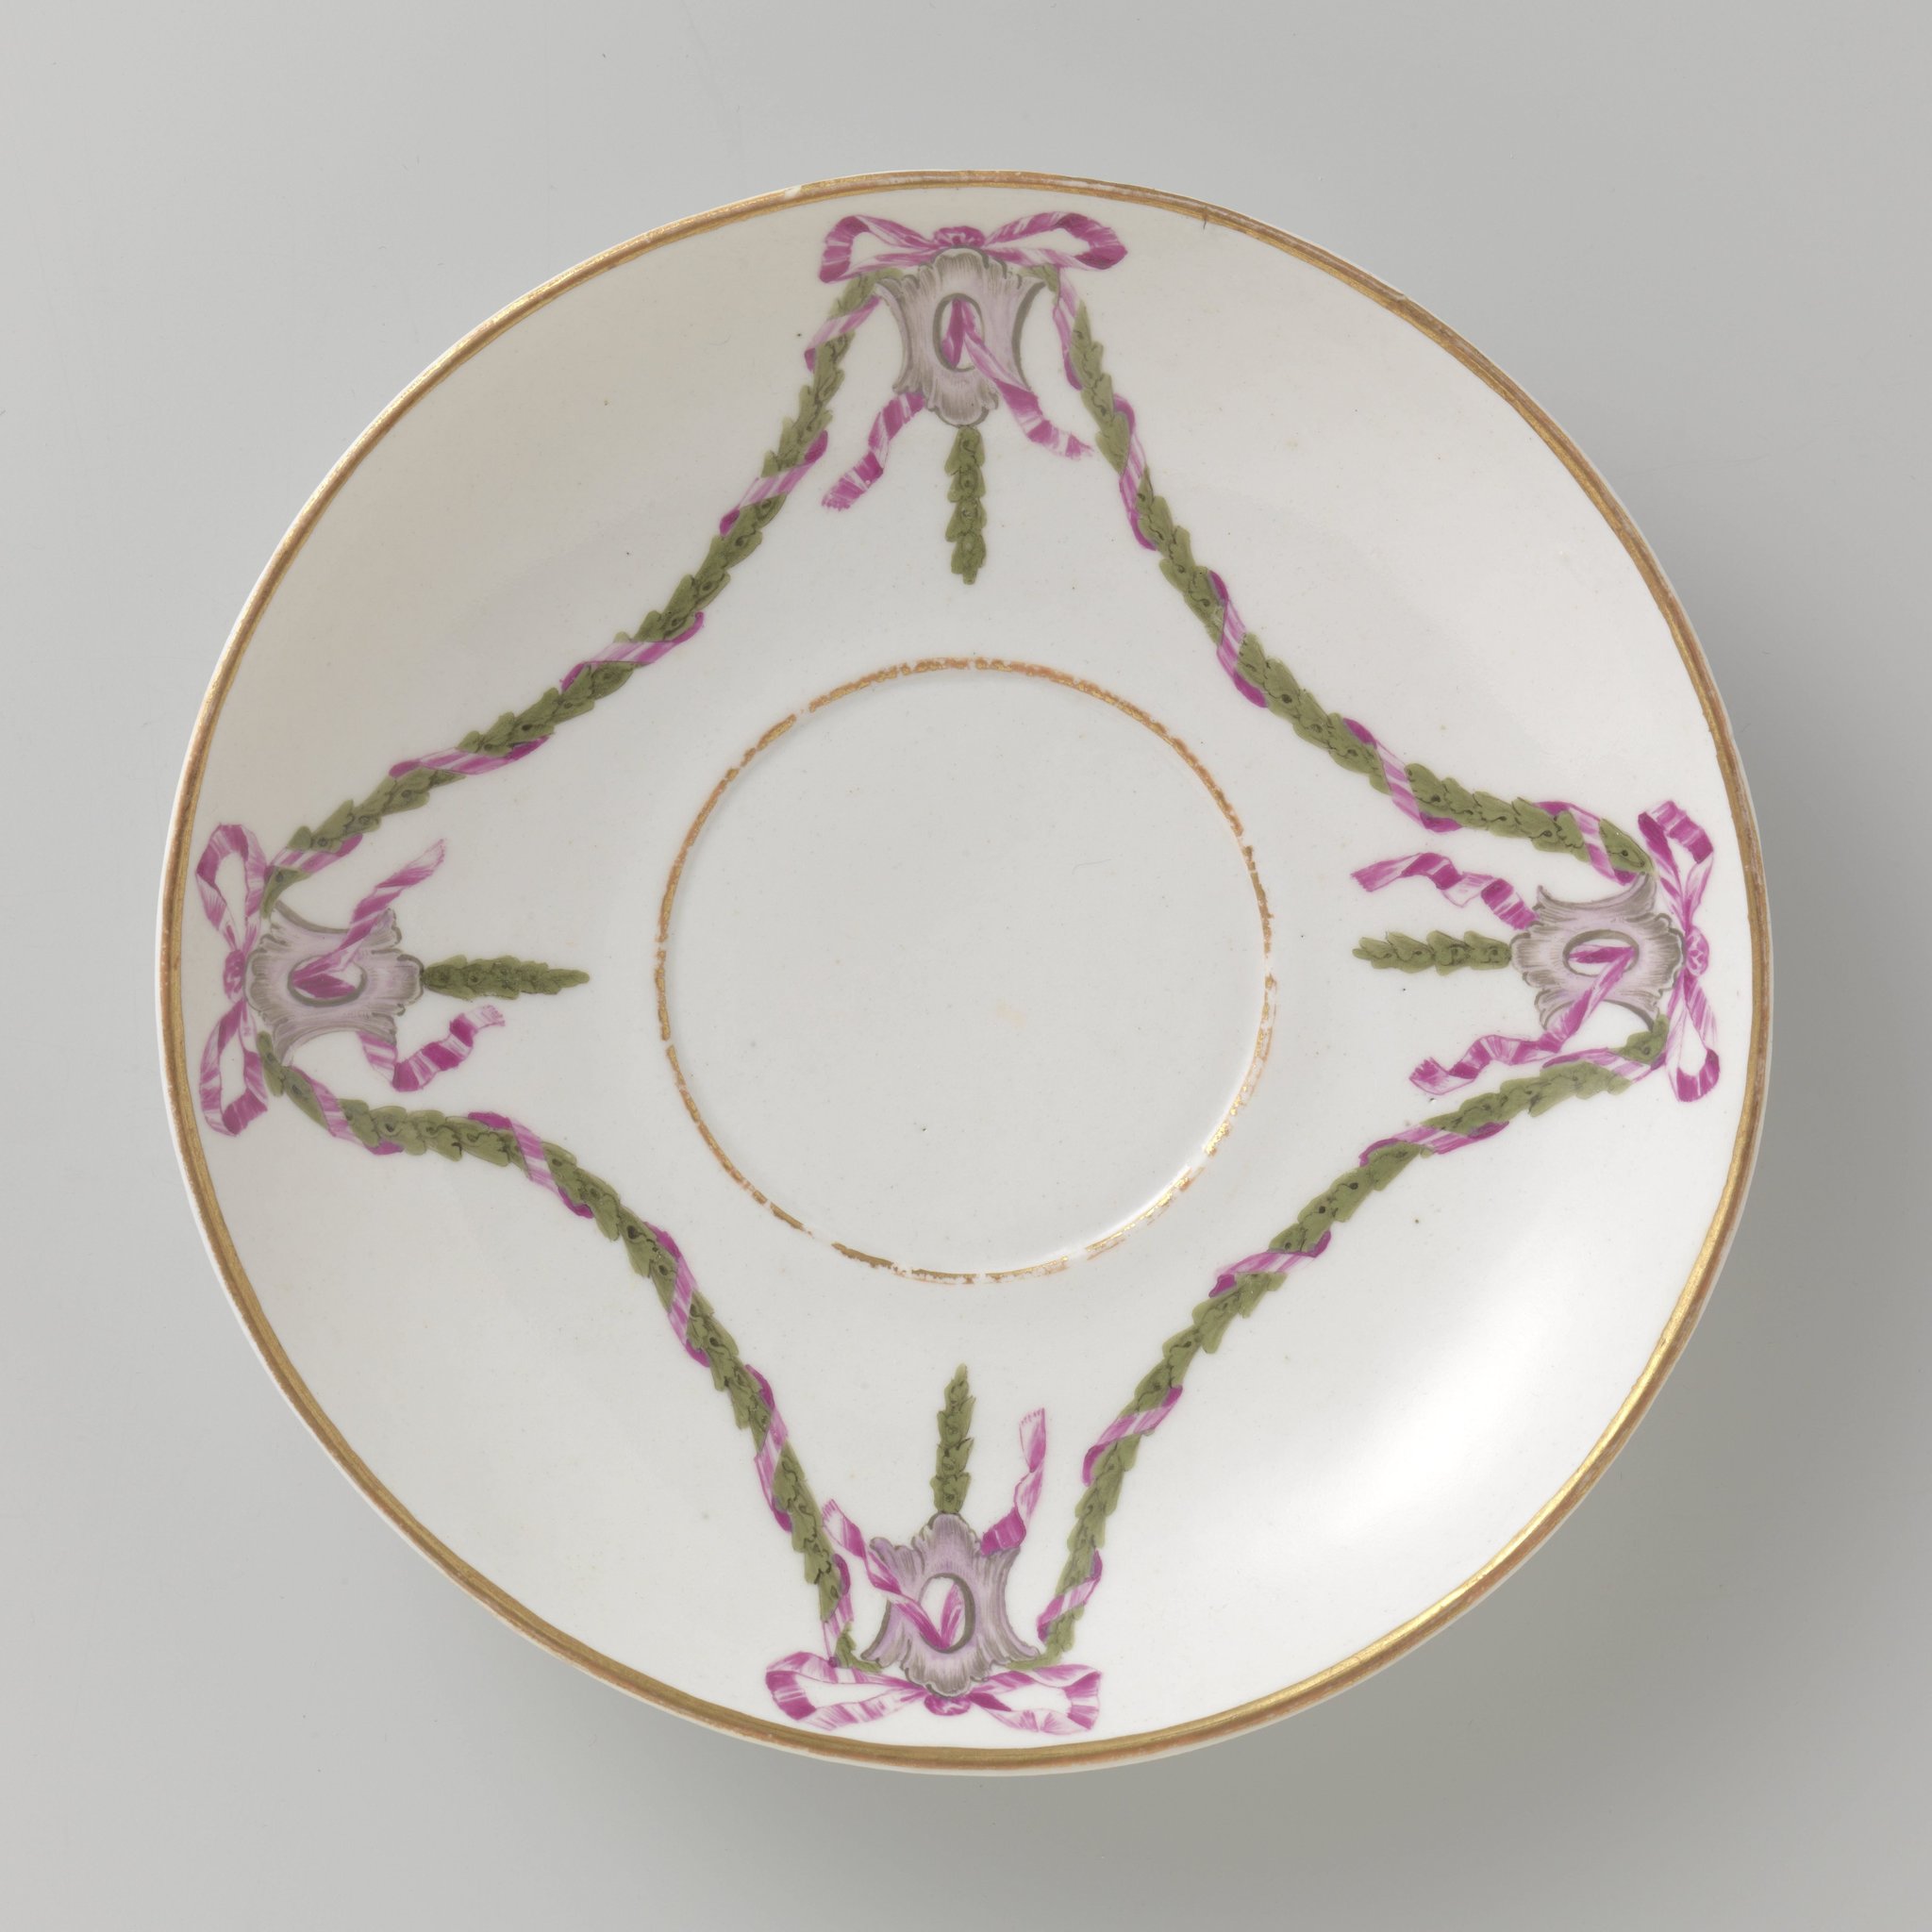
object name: platter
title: Tureen and stand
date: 1778-1782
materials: porcelain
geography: loosdrecht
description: Manufactuur Oud-Loosdrecht Loosdrecht, c. 1778–1782 hard-paste porcelain